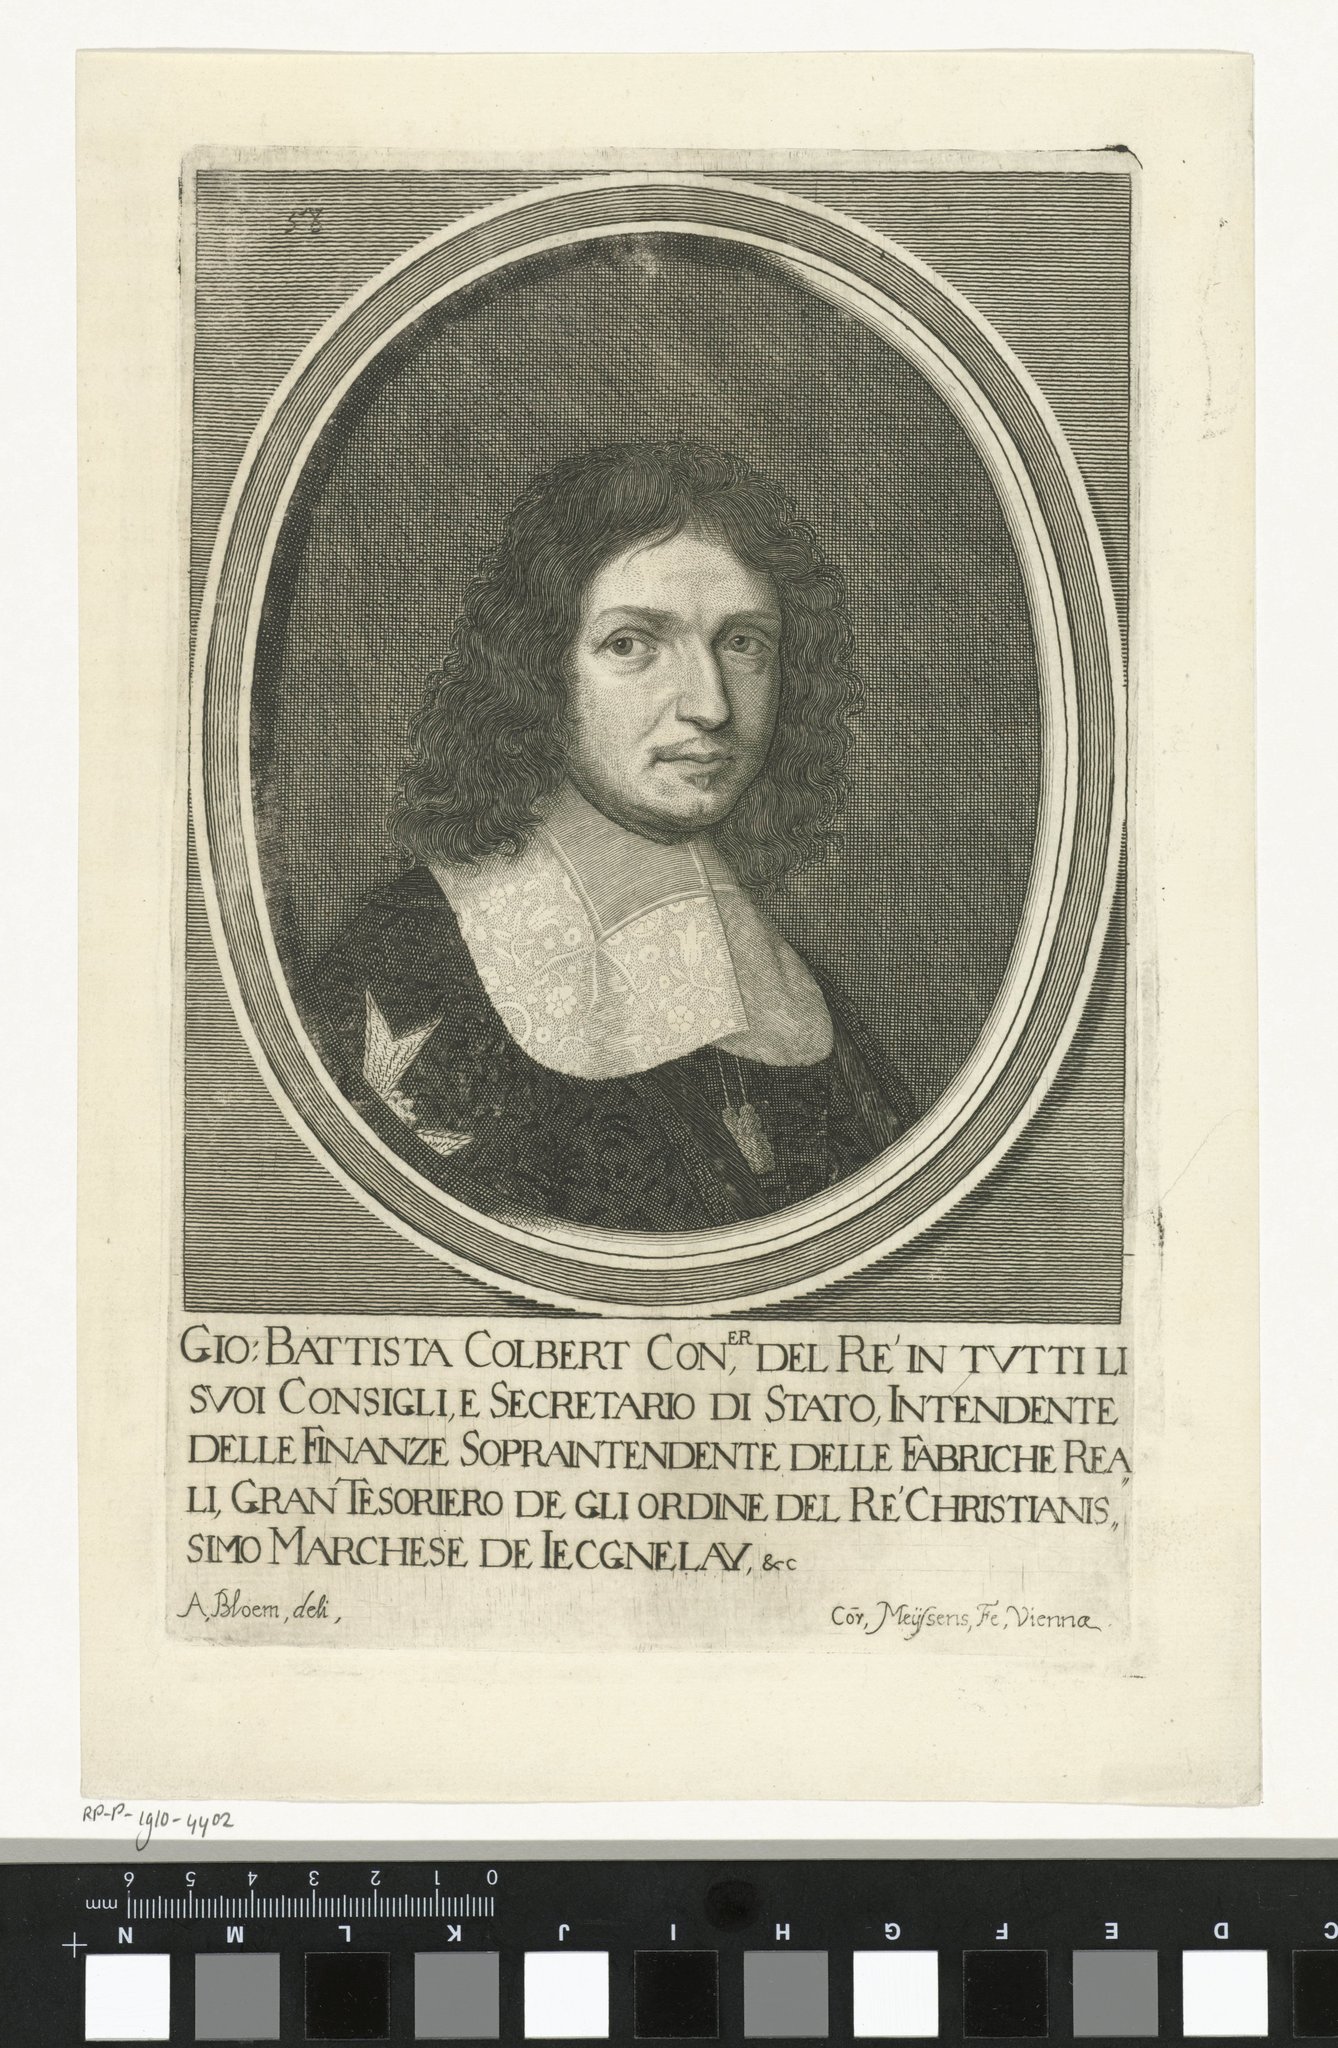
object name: book illustration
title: Portret van Jean-Baptiste Colbert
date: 1670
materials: paper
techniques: engraving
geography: vienna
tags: paris, politician, jean-baptiste colbert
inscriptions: collector's mark: Lugt 2228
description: Prent gebruikt in: Gualdo Priorato, Galeazzo. Historia di Leopoldo Cesare, (...). 3 dln. Wenen, Giovanni Battista Hacque, 1670-1674, dl. 2.